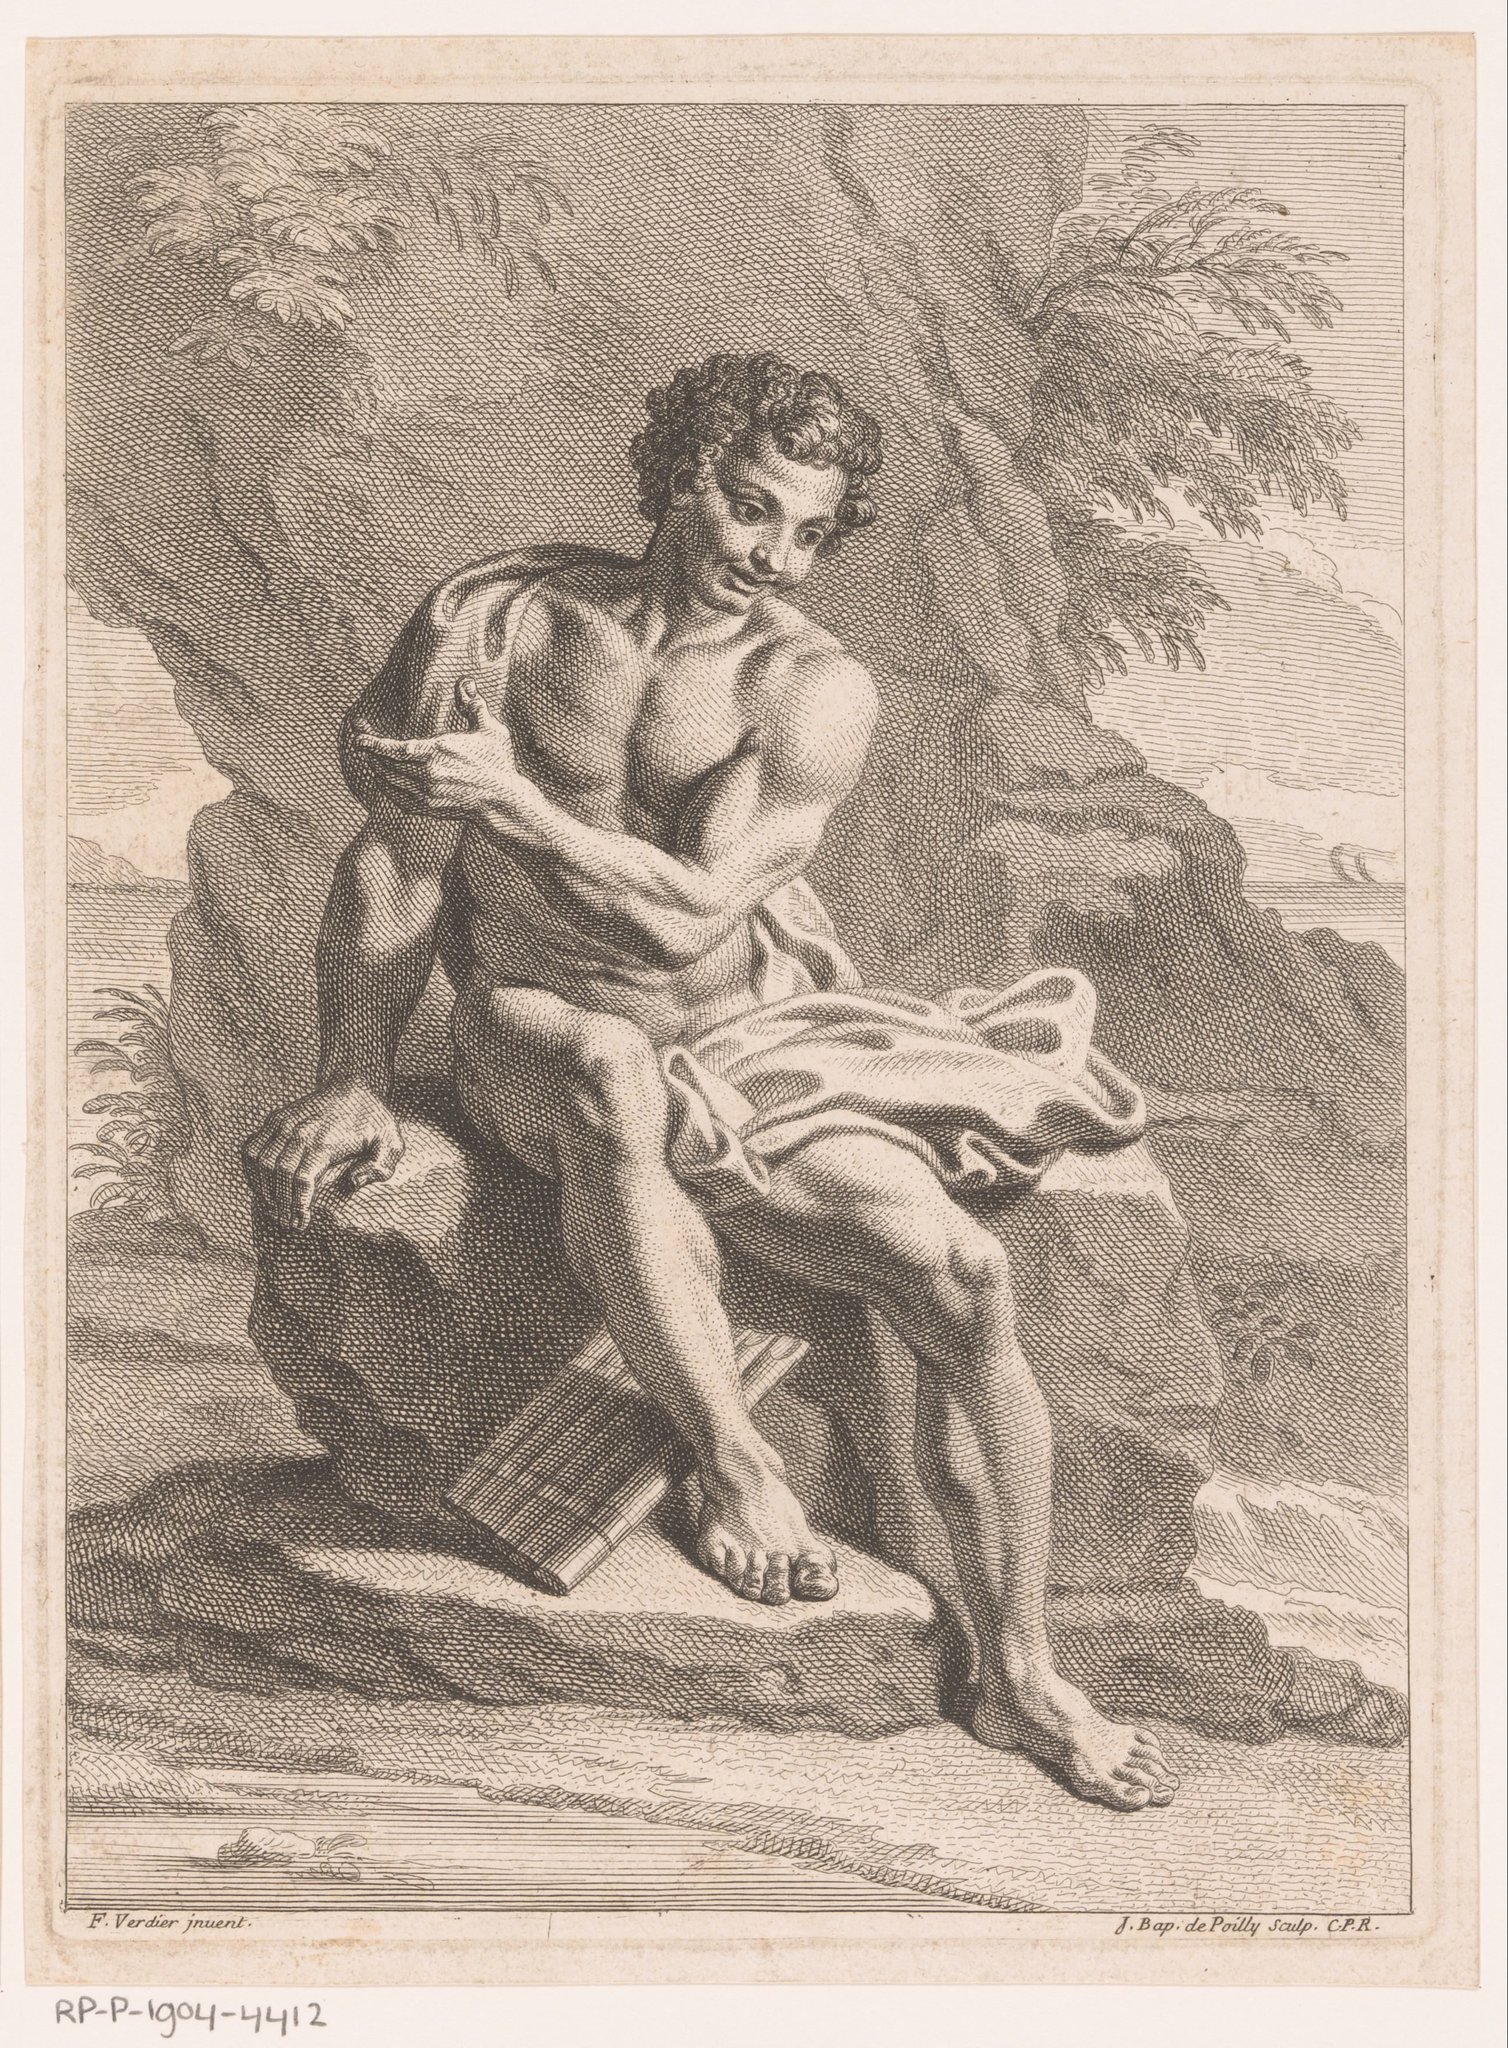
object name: print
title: Recueil de plusieurs Figures d'Academie, Dessinée d'apres le Naturel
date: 1679-1728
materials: paper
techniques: engraving, etching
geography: france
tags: youth, adolescent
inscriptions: collector's mark: Lugt 2228